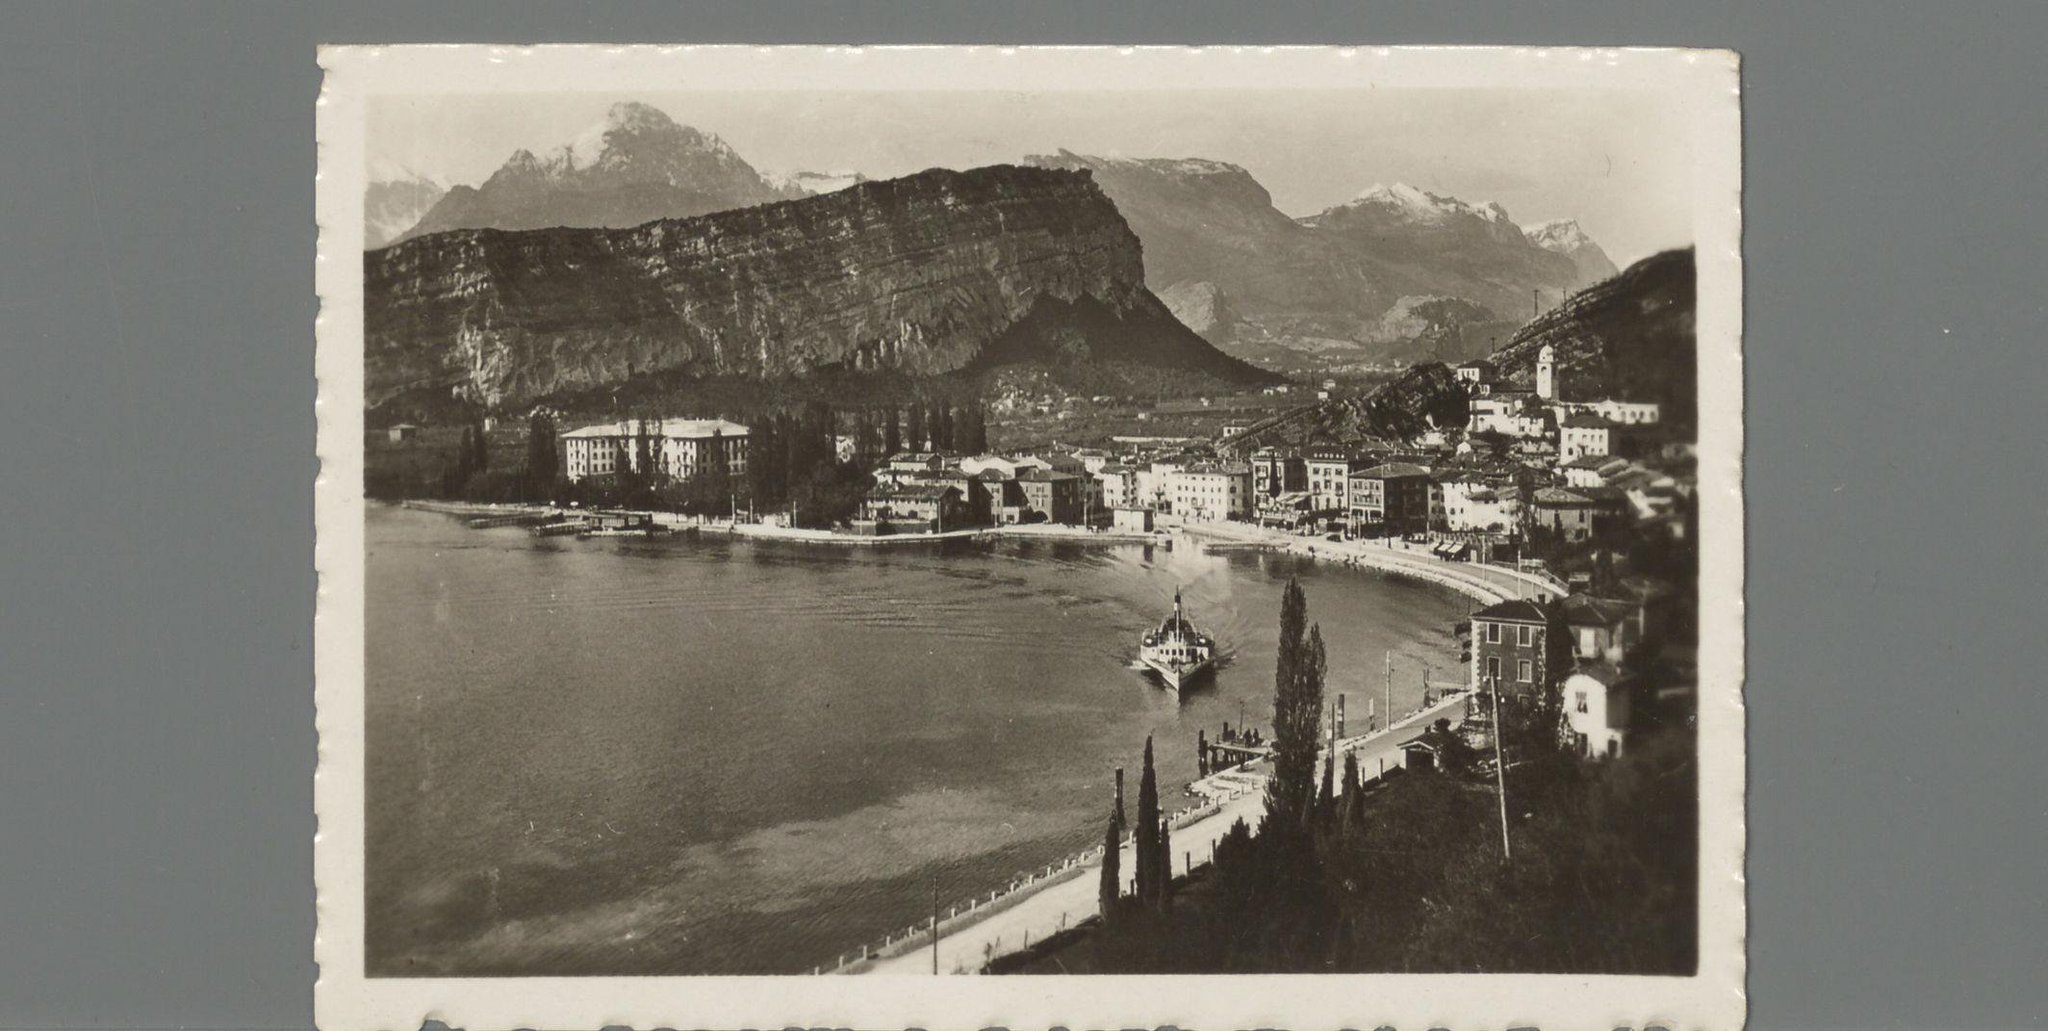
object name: photograph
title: Lago di Garda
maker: s. pozzini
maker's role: publisher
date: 1925-1935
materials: paper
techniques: gelatin silver print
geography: torbole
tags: prospect of village, silhouette of village, lake, mountains